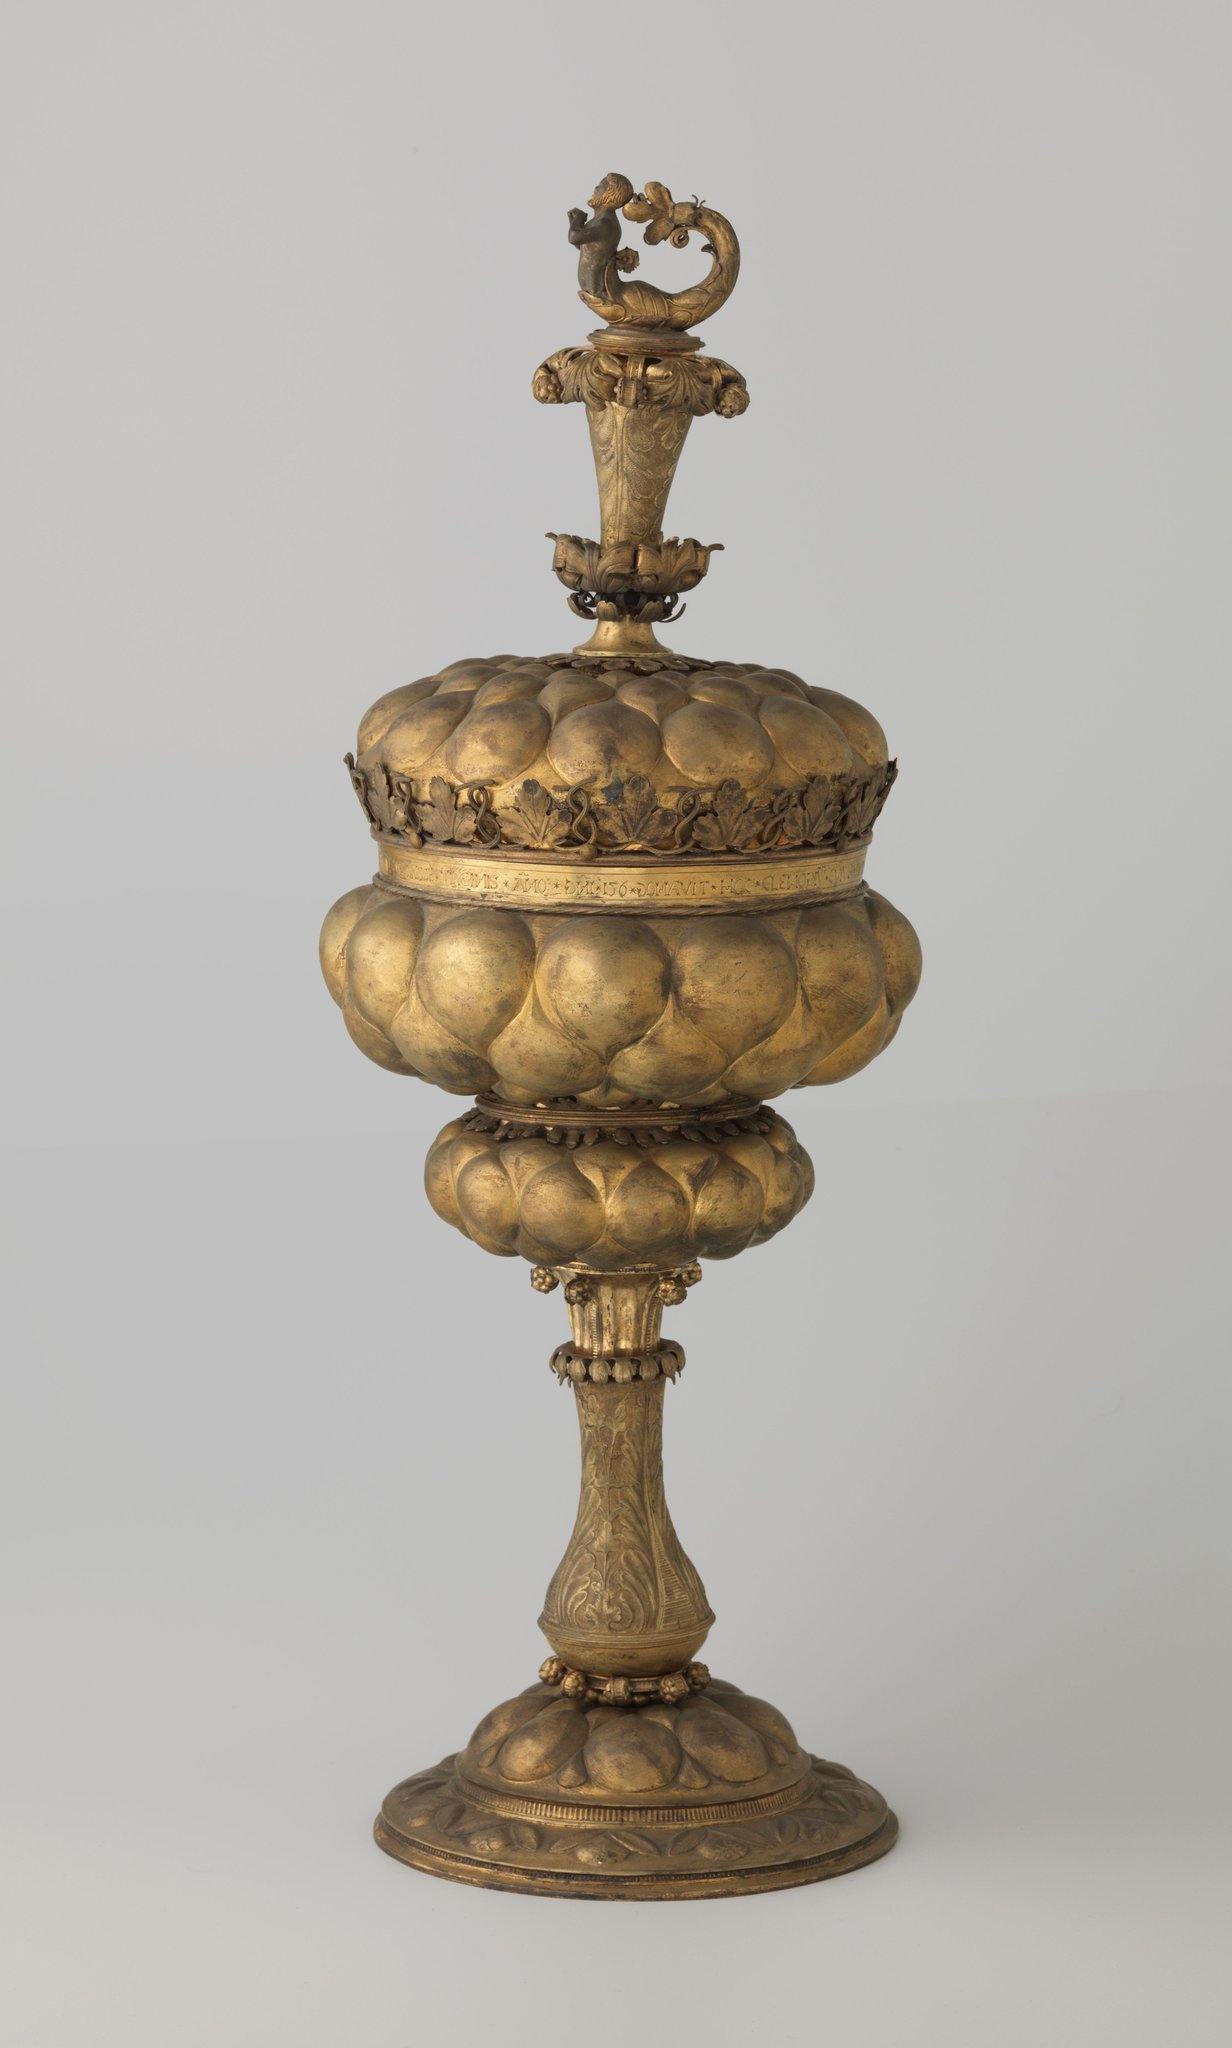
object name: lid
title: Galvanoplastische reproductie van een deksel horend bij een bokaal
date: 1533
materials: copper, silver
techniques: gilding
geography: berlin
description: Galvanoplastische reproductie van een deksel horend bij een bokaal van verguld zilver, bekend als de Pocal mit Jonas van 156 (zie BK-NM-5356-1).